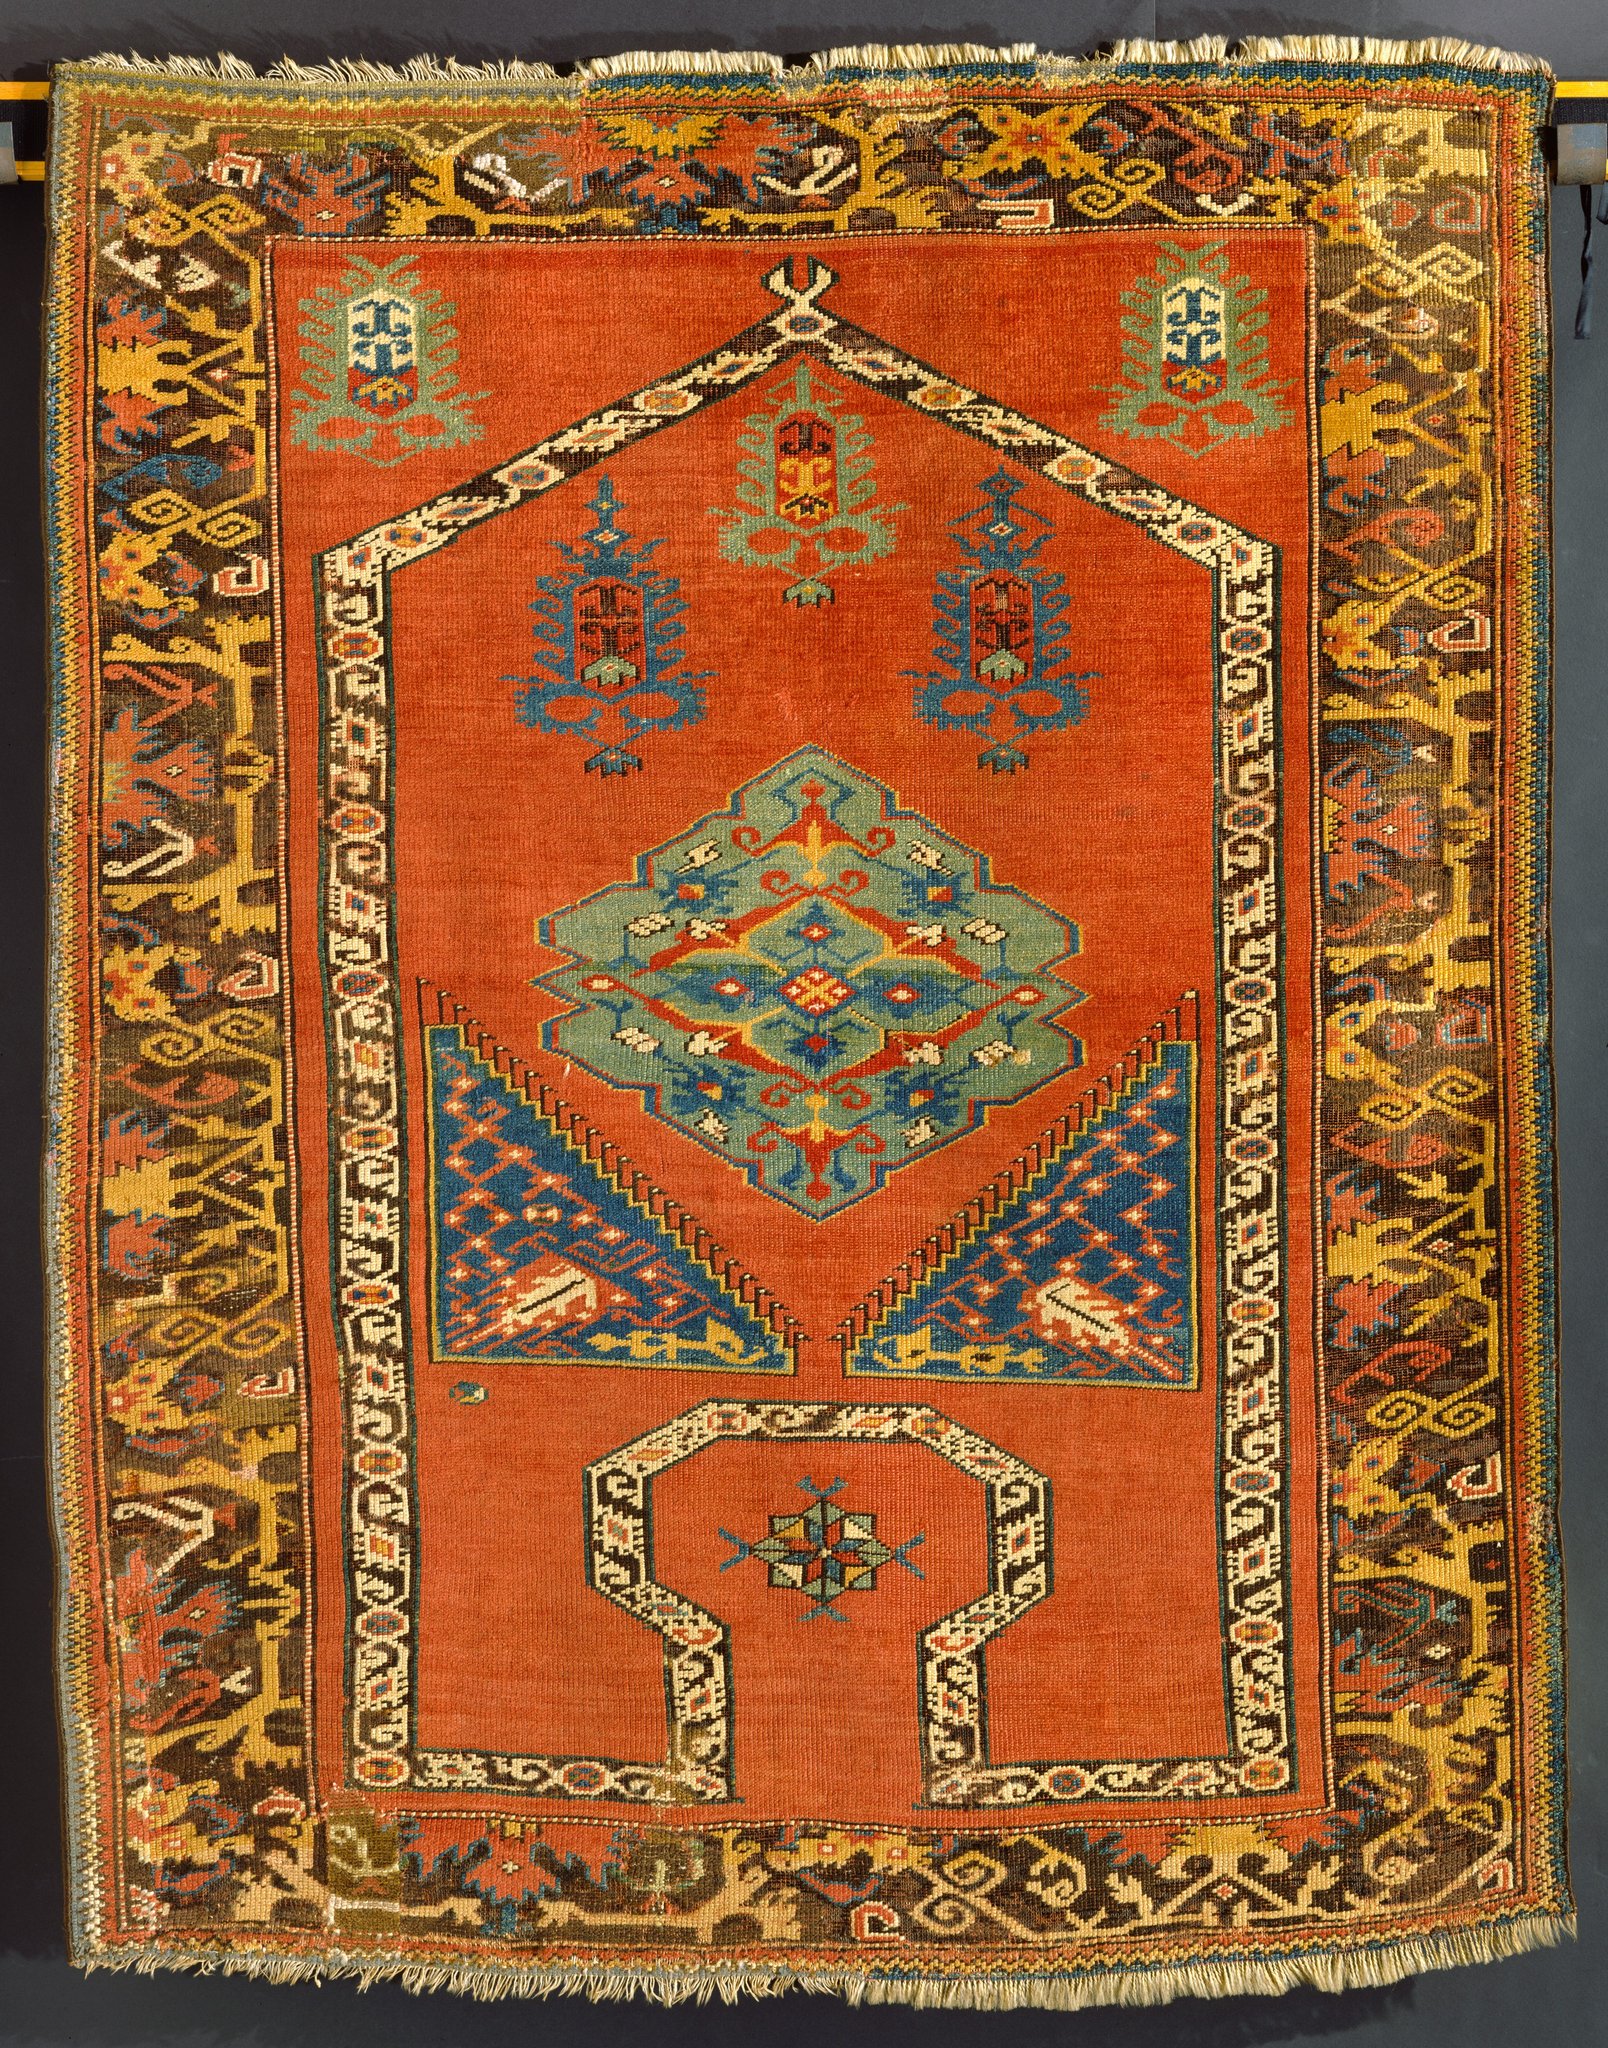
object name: carpet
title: "Bellini" Carpet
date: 1501-1700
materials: wool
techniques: pile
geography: turkey